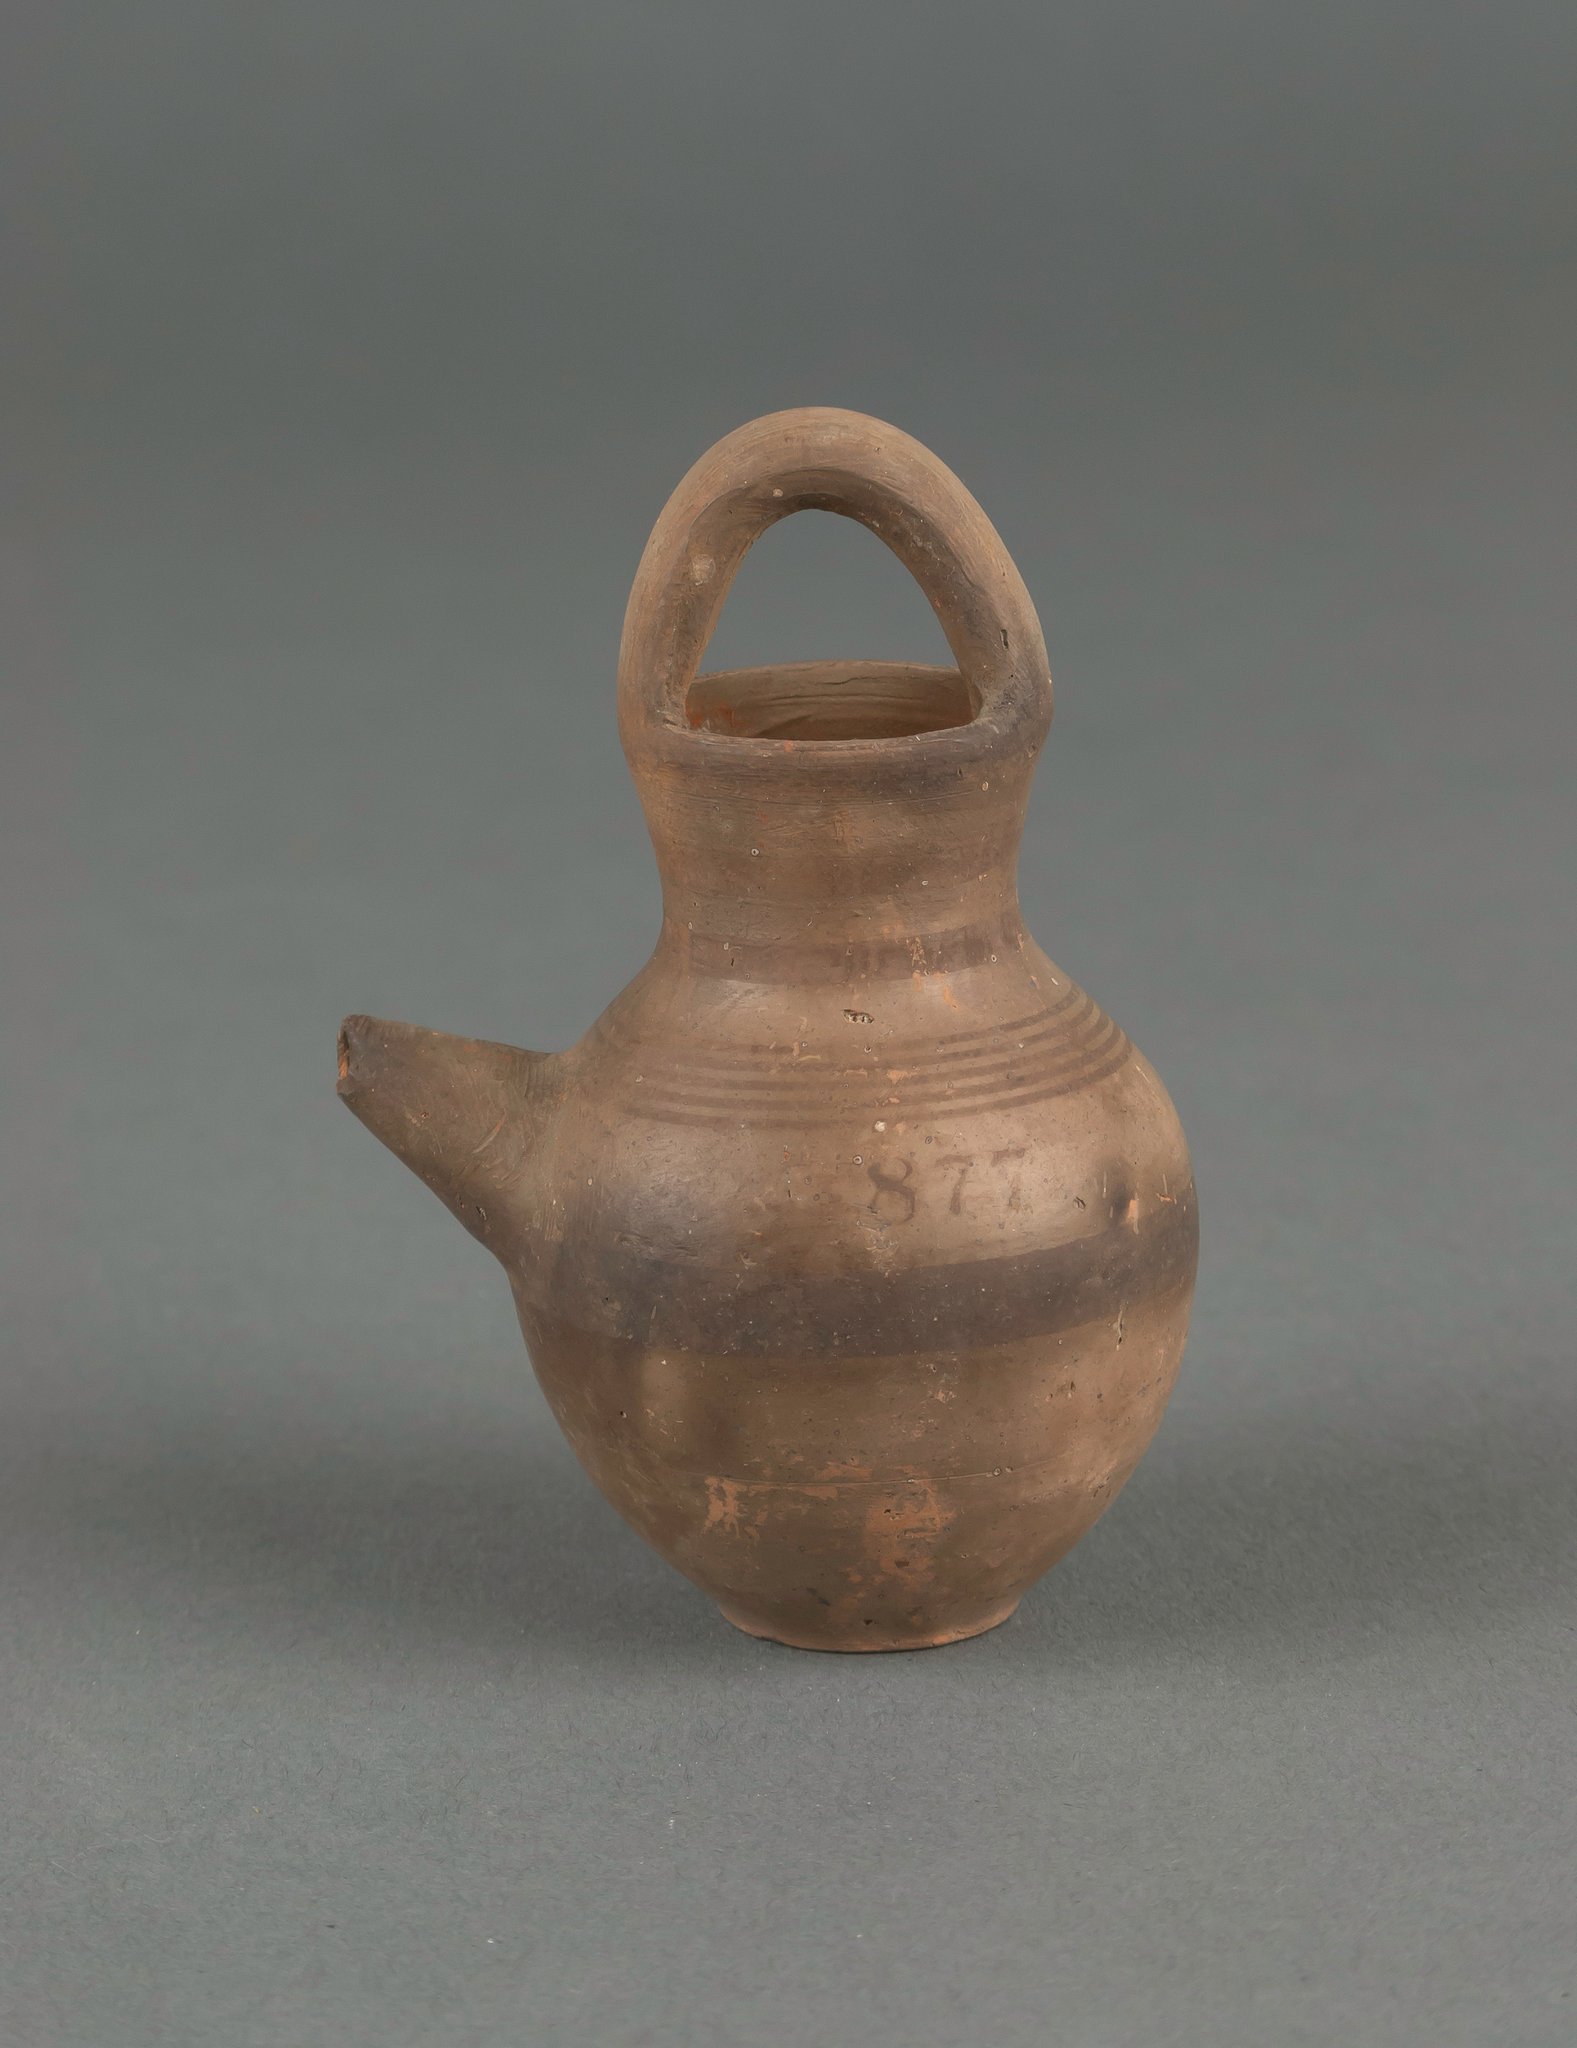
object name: juglet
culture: cypriot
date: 750-600 BCE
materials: terracotta